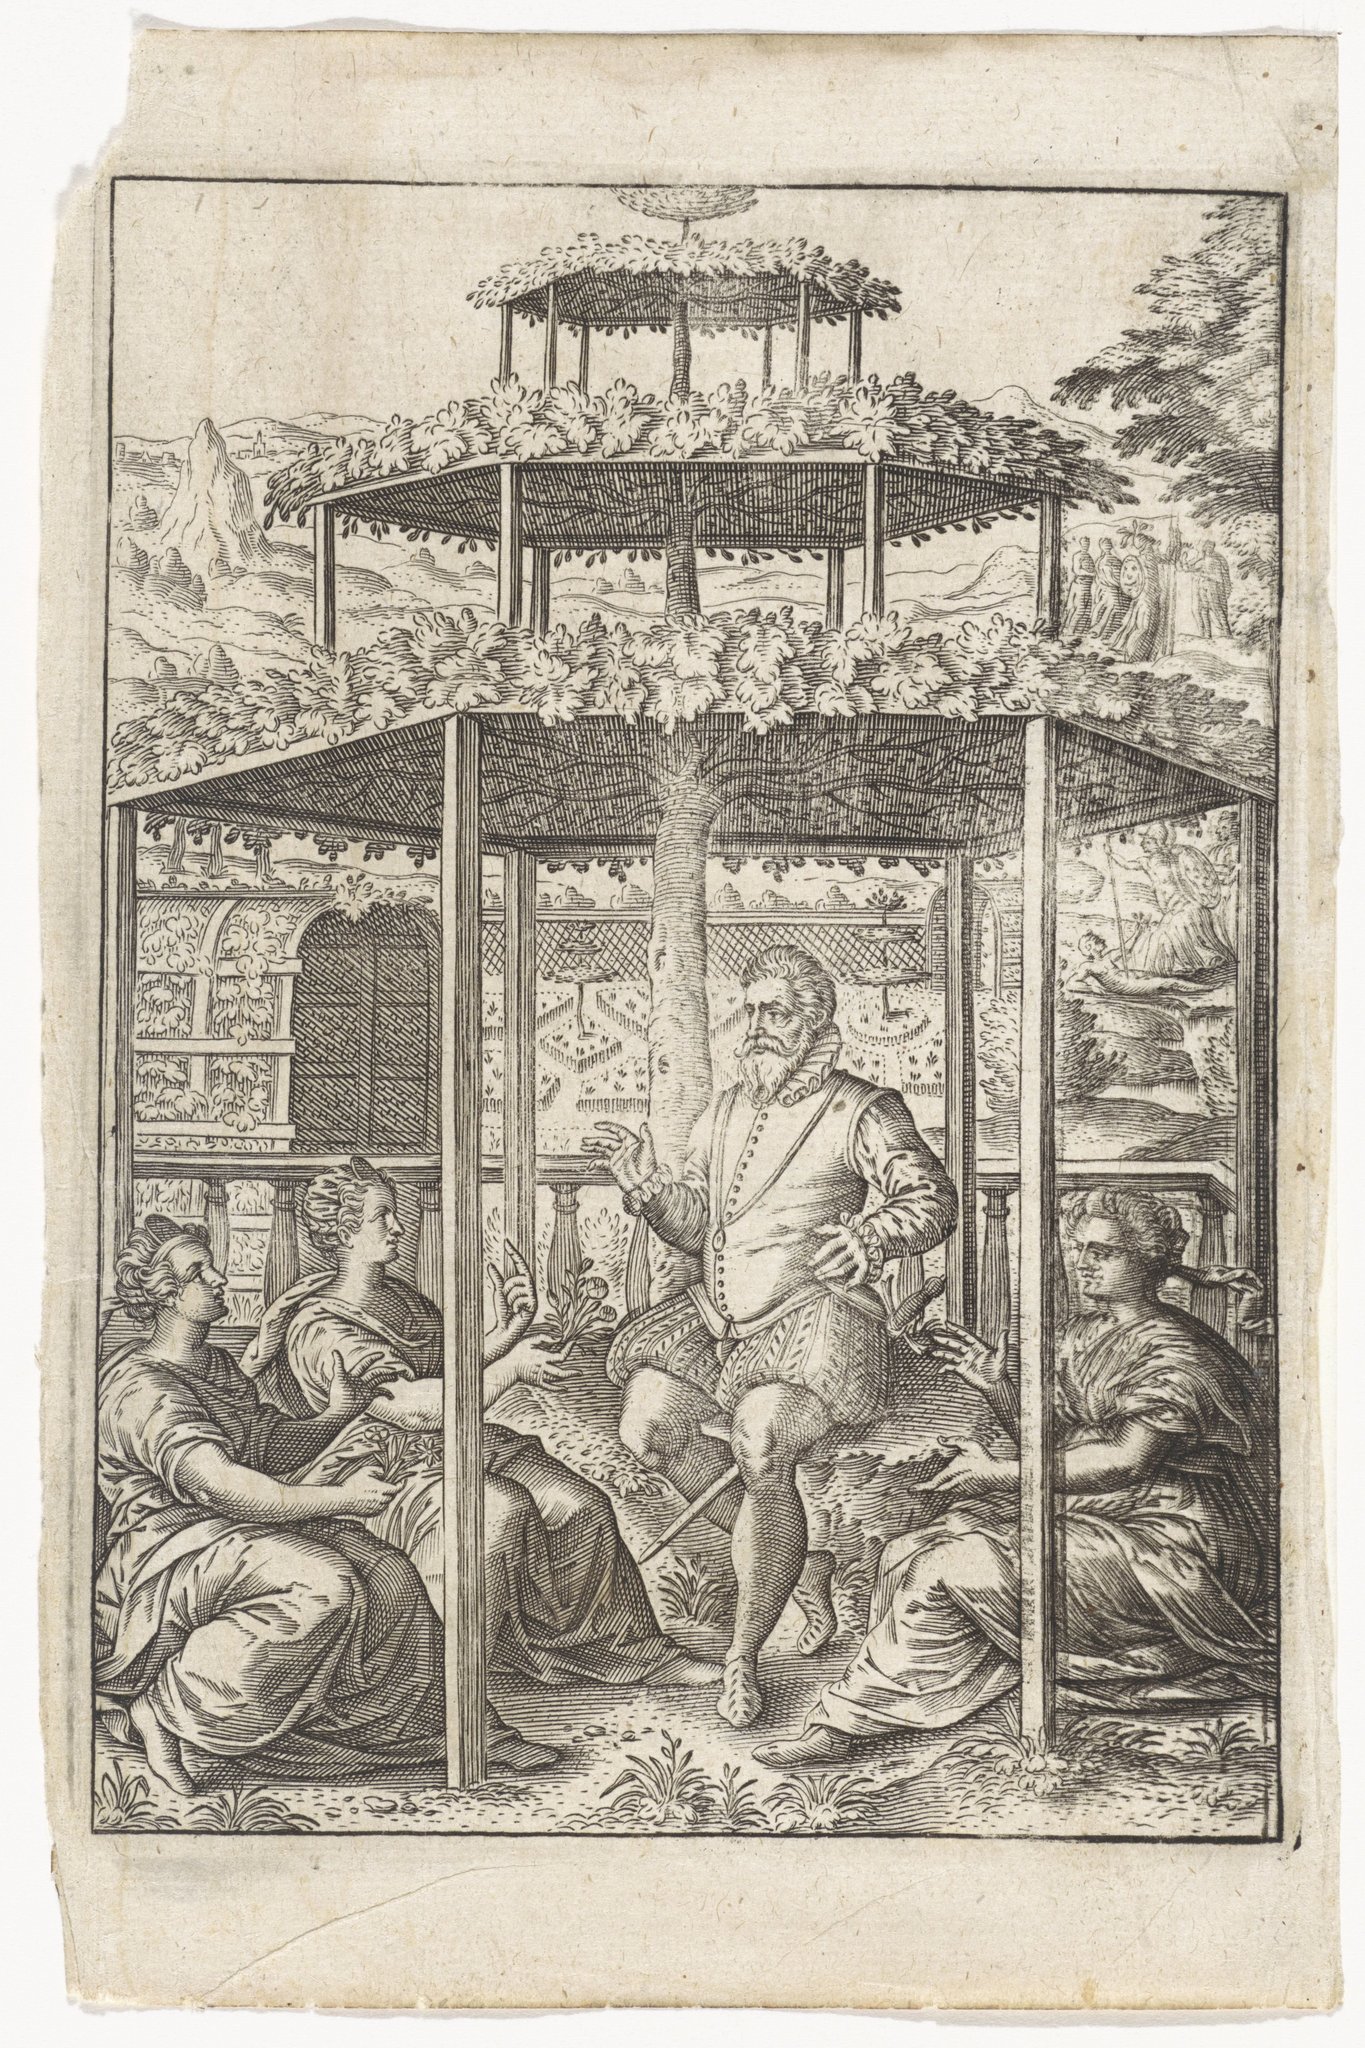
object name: print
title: Man vertelt een verhaal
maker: Anonymous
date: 1614-1616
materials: paper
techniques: engraving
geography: antwerp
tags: portrait of a writer, summer-house, arbour, garden-house (dutch: 'theekoepel')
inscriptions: collector's mark: Lugt 2228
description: Prent uit: Houwaert, Johan Baptista. Pegasides pleyn. ofte Den lust-hof der maechden, 16 delen. Rotterdam: Jan Leendertsz Berewout, 1614-1616.